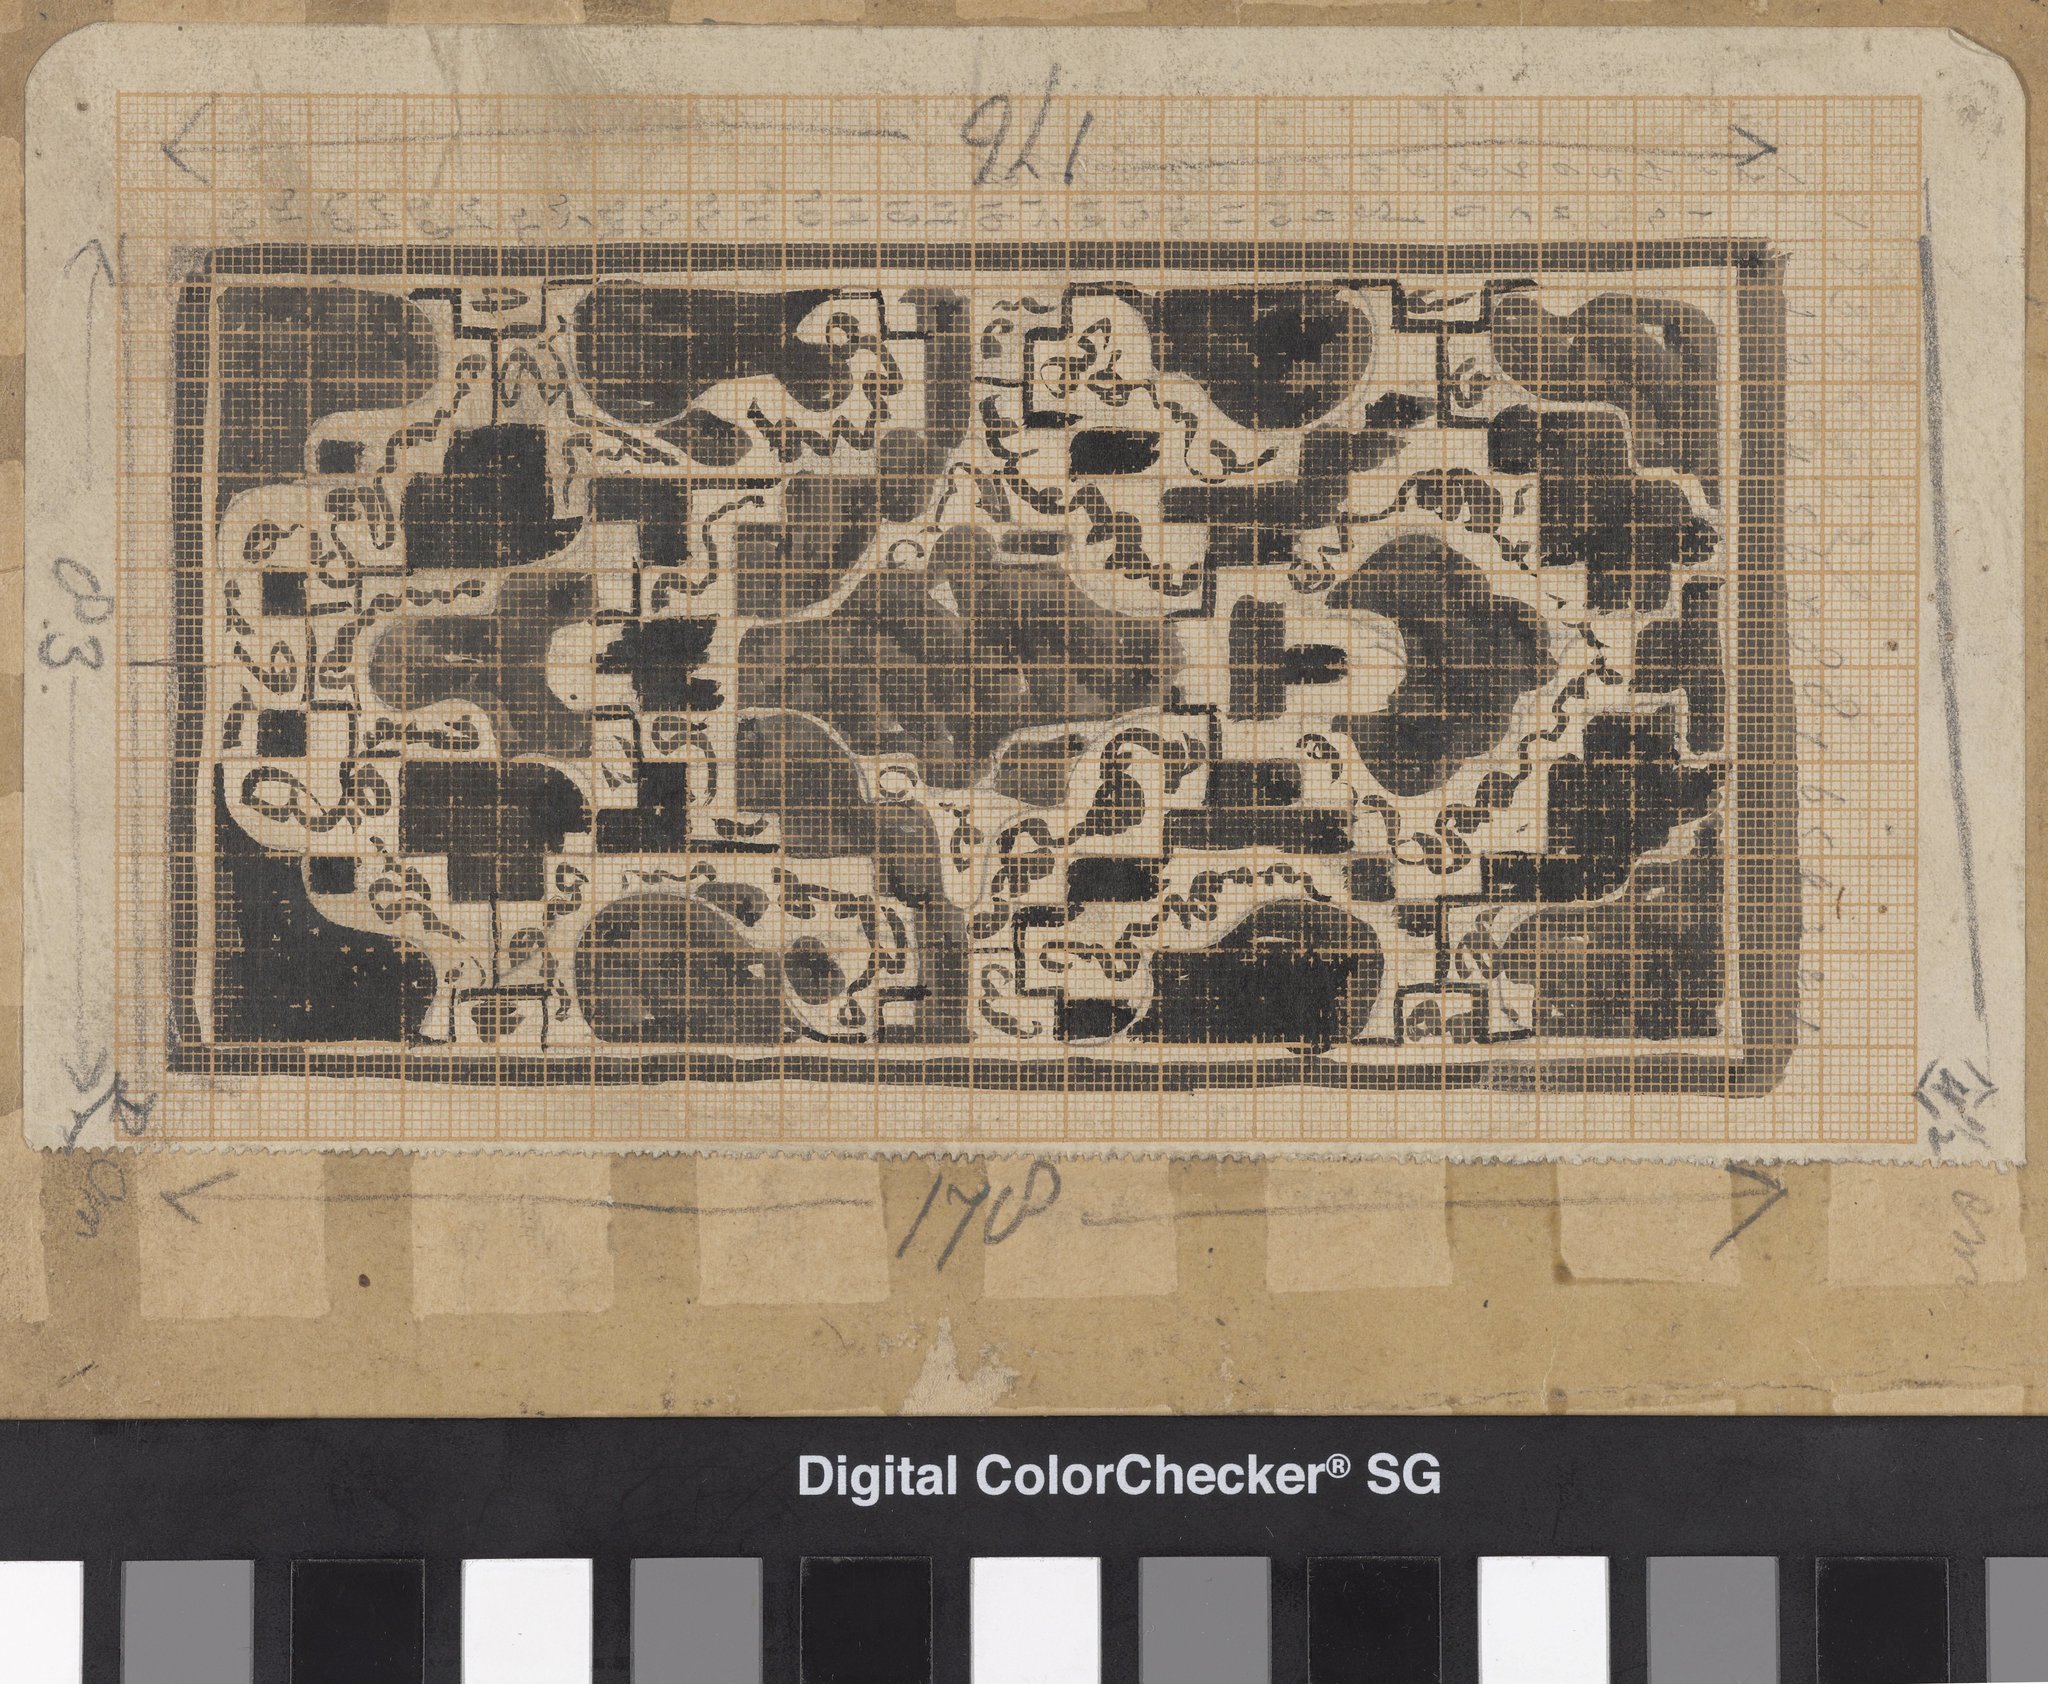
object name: design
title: Ontwerp voor een kleed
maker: carel adolph lion cachet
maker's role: draughtsman, print maker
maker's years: 1864-1945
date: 1874-1945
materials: pencil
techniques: brush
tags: carpet, rug, tapestry